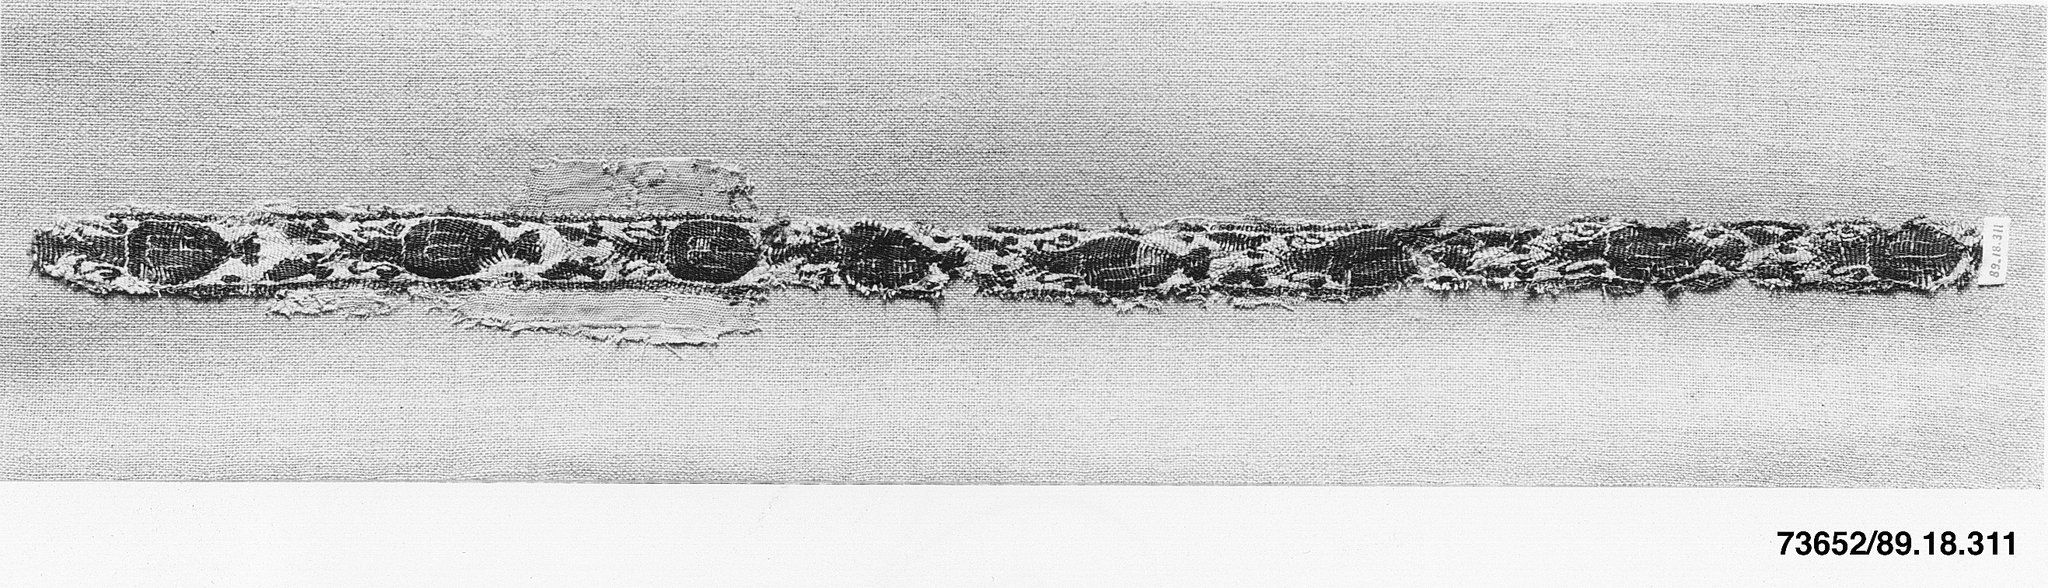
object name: textile fragment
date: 201-400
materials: linen, wool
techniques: weave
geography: egypt